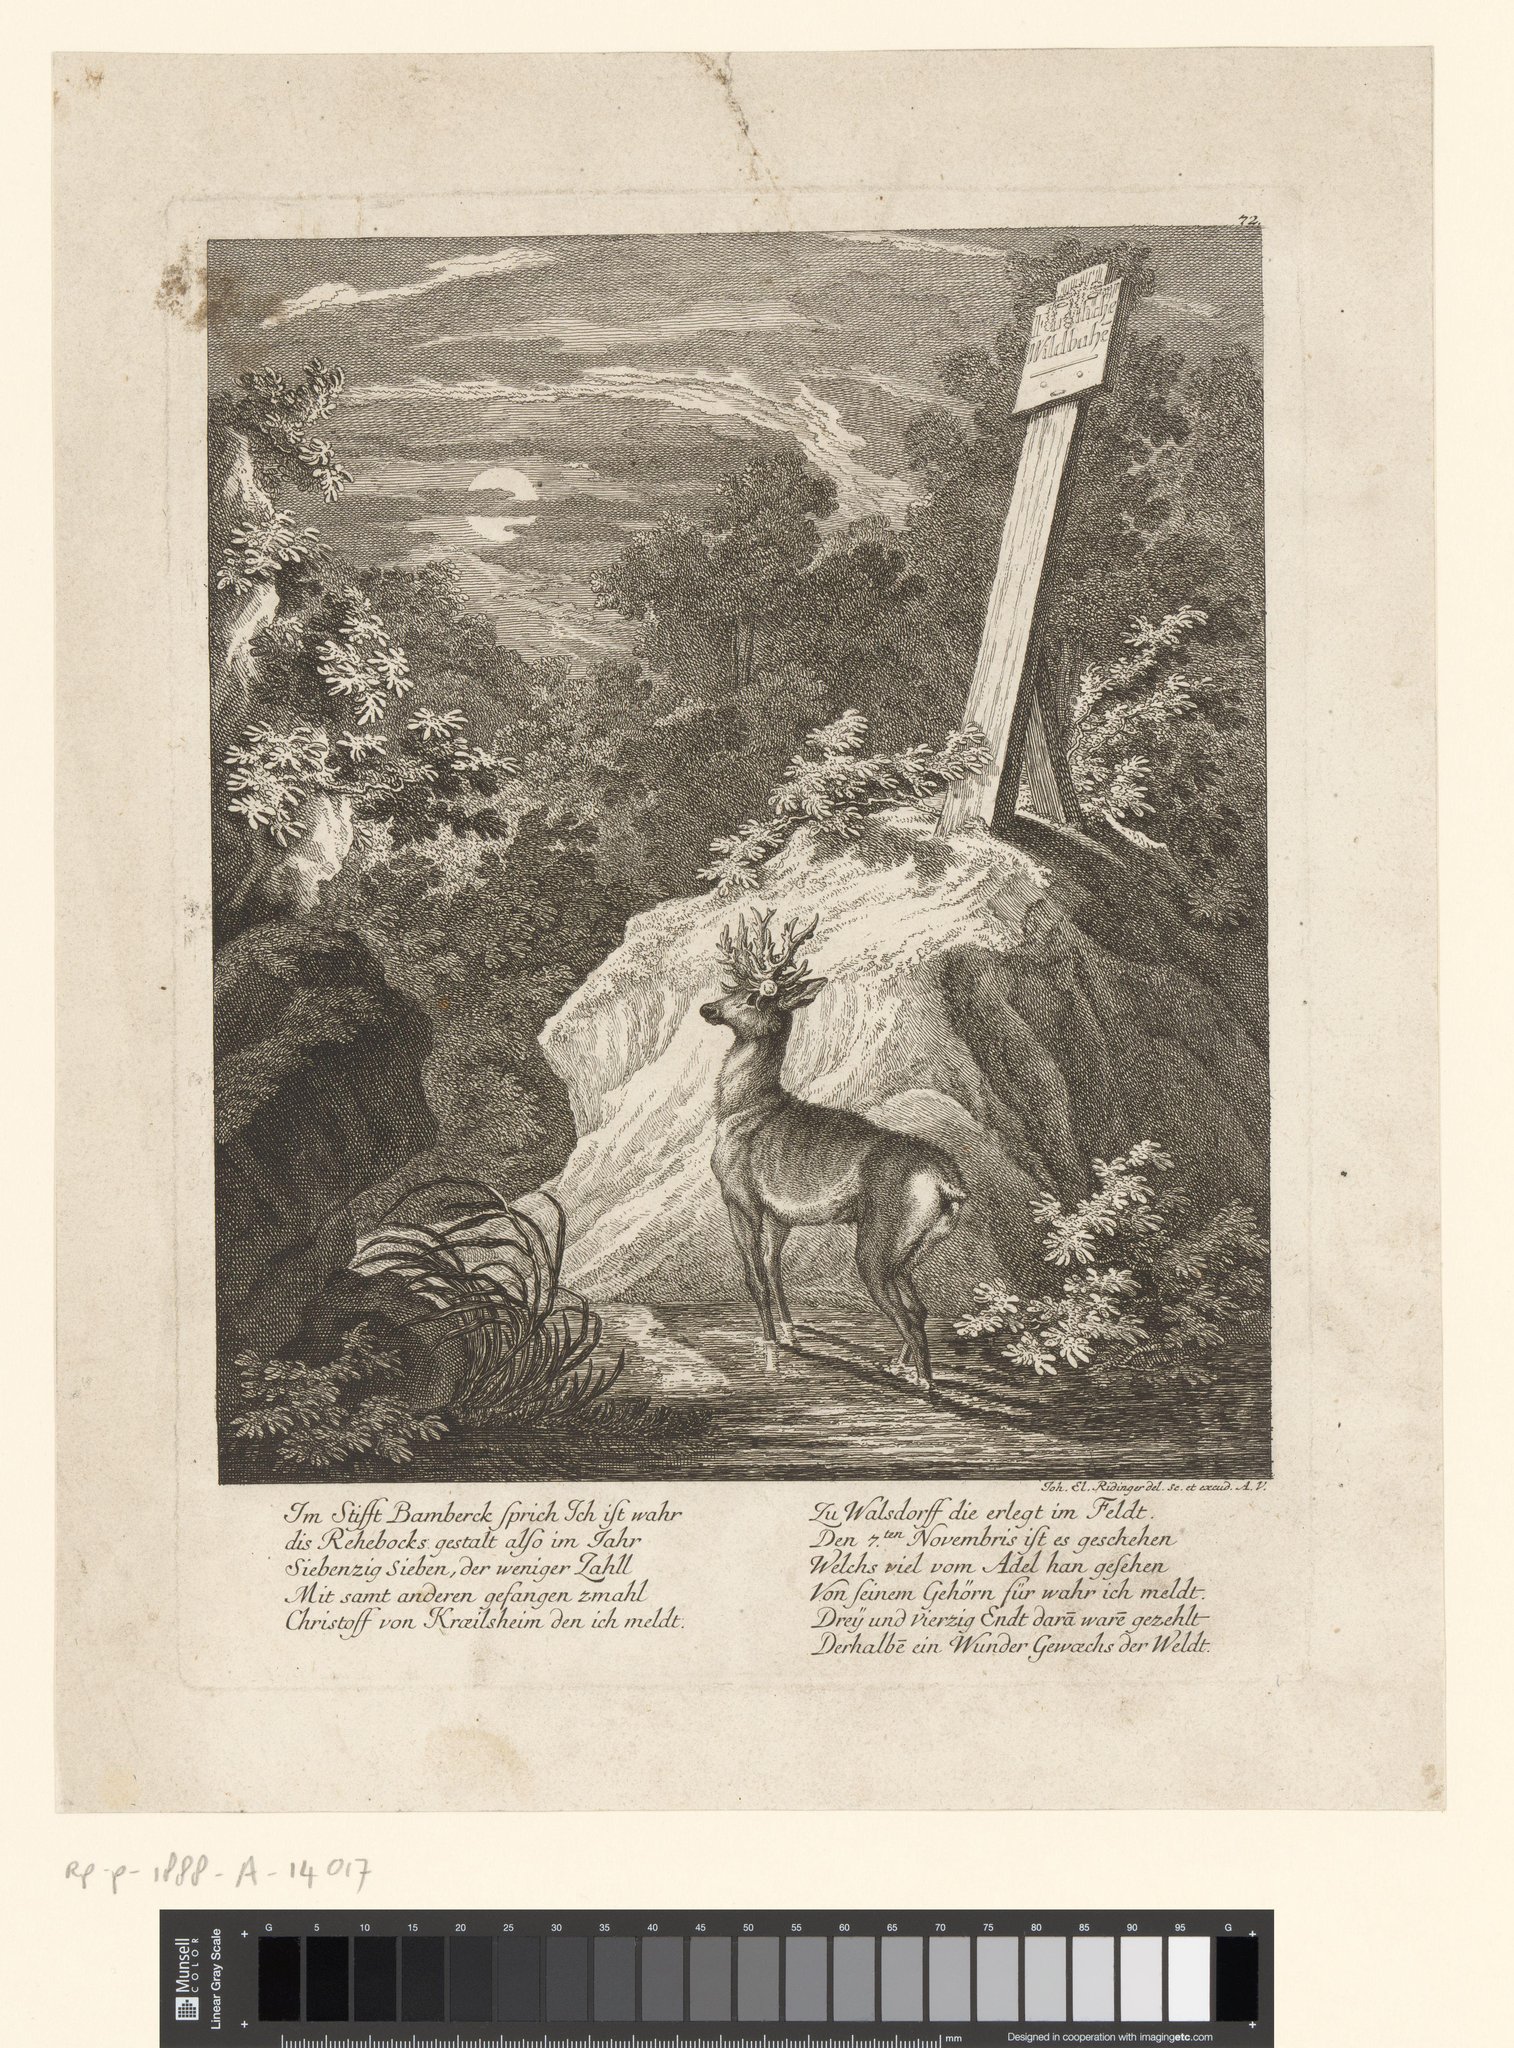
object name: print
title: De 100 meest wonderlijke herten en andere dieren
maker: johann elias ridinger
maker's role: draughtsman, painter, print maker, publisher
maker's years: 1698-1767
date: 1708-1767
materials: paper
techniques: etching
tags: hoofed animals: deer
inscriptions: collector's mark: Lugt 2228